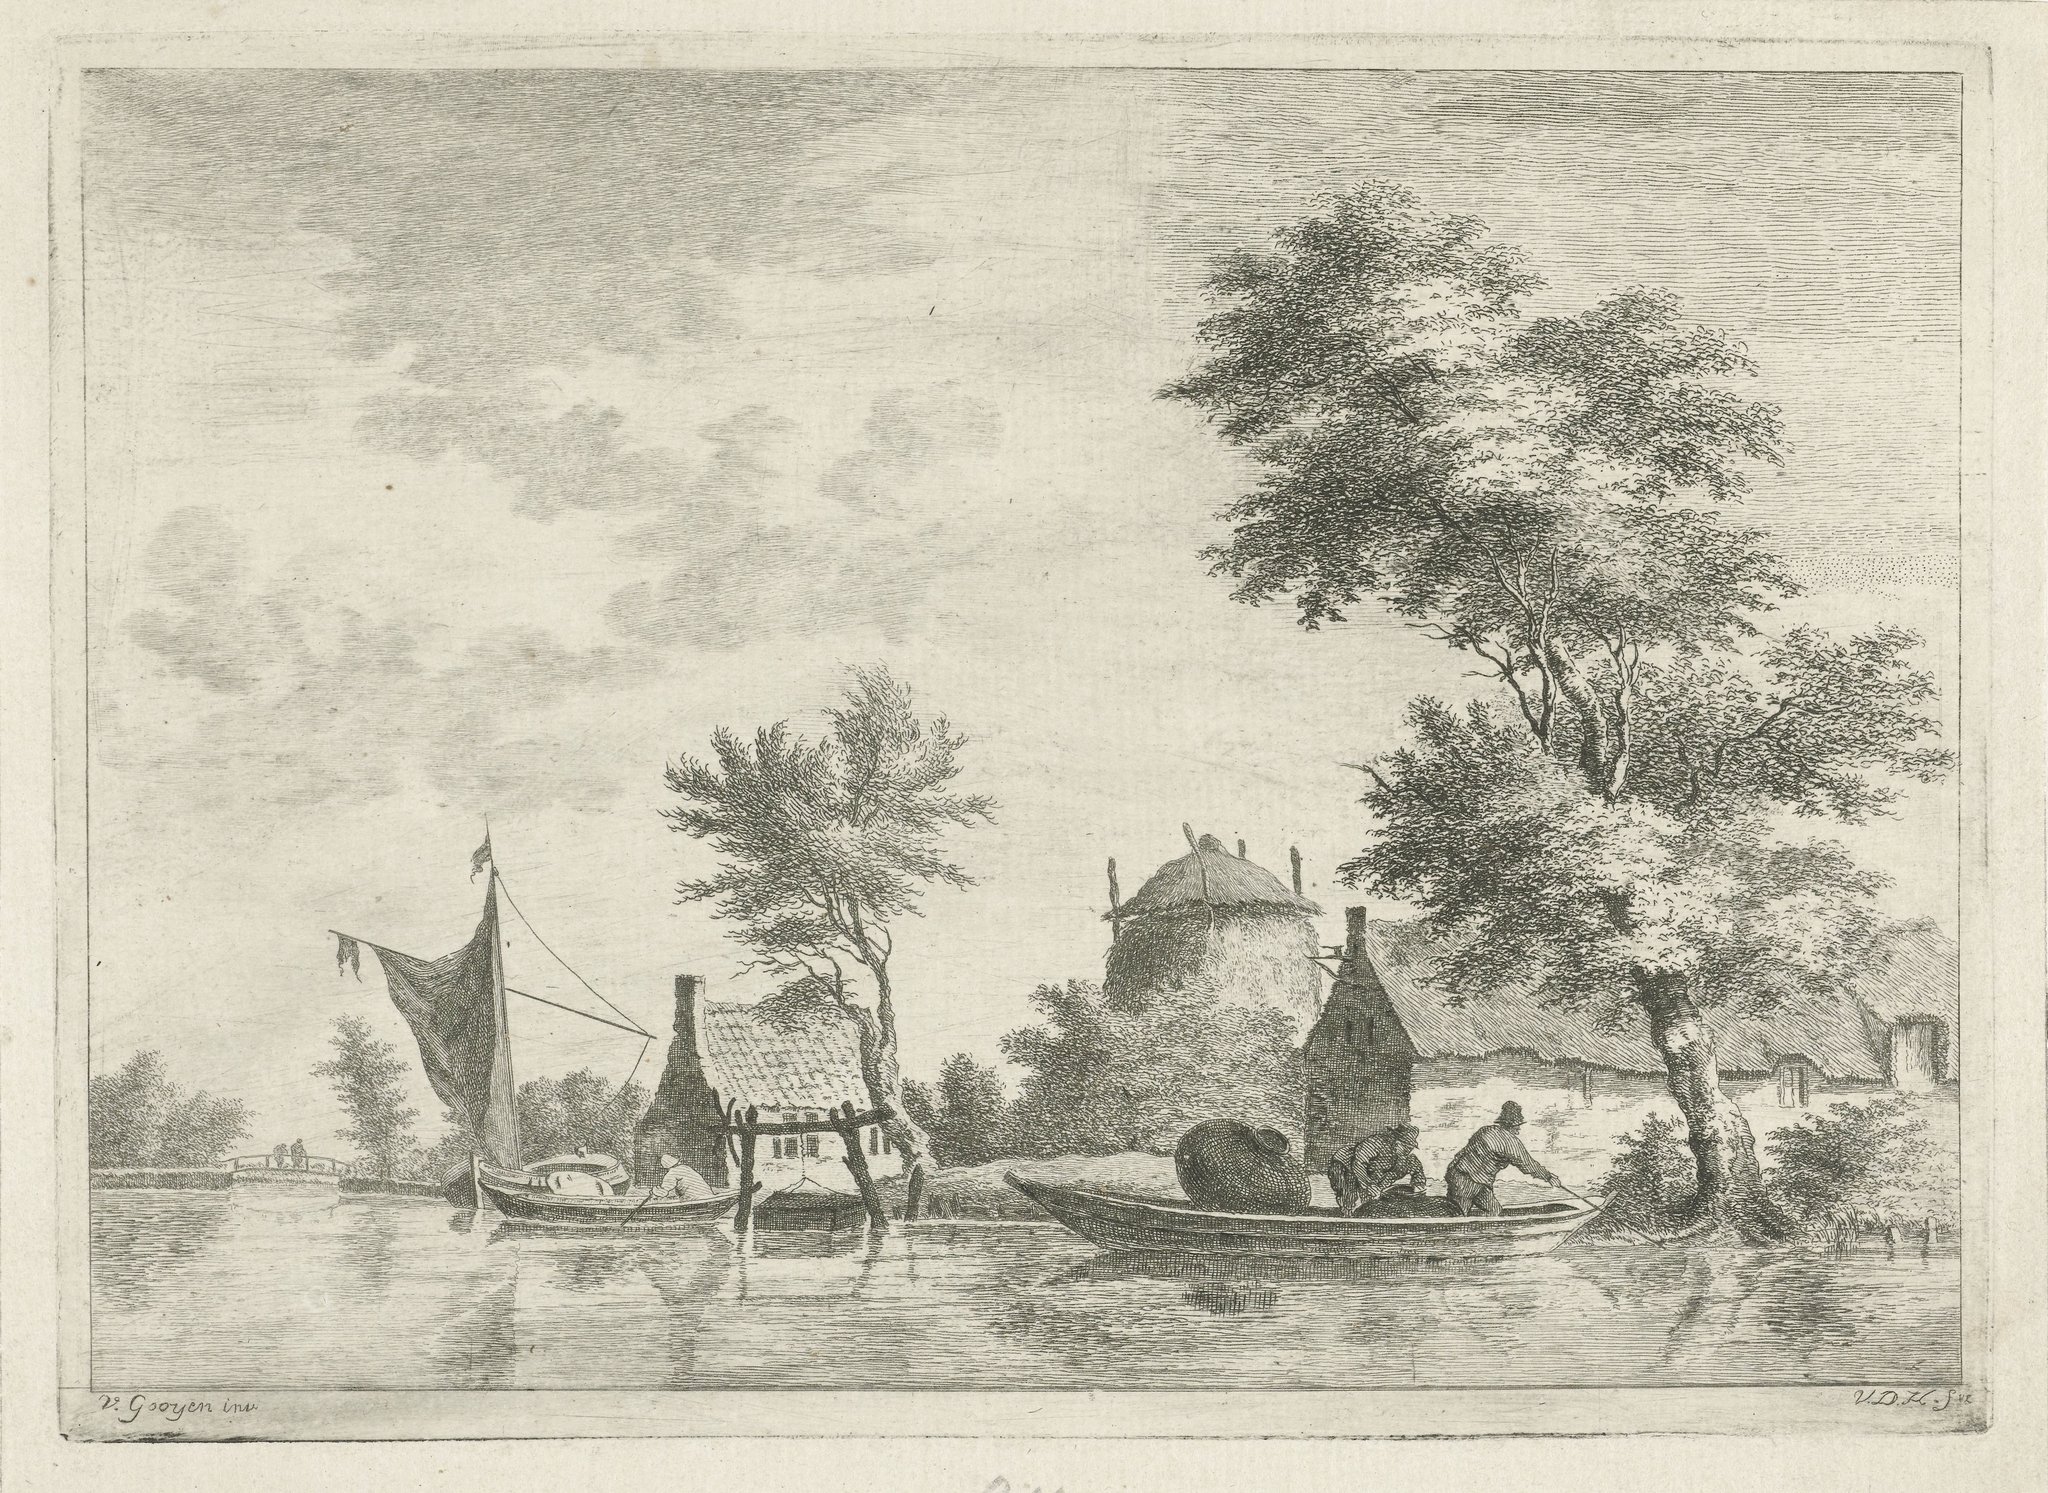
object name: print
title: Rivierlandschap met een hooiberg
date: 1745-1785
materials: paper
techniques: etching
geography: northern netherlands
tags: rowing-boat, canoe, etc., hay-stack, landscapes with waters, waterscapes, seascapes (in the temperate zone) (+ landscape with figures, staffage), farm or solitary house in landscape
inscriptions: collector's mark: Lugt 2228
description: Op de oever van een rivier ligt een boerderij met hooiberg. Op het water enkele schuiten.